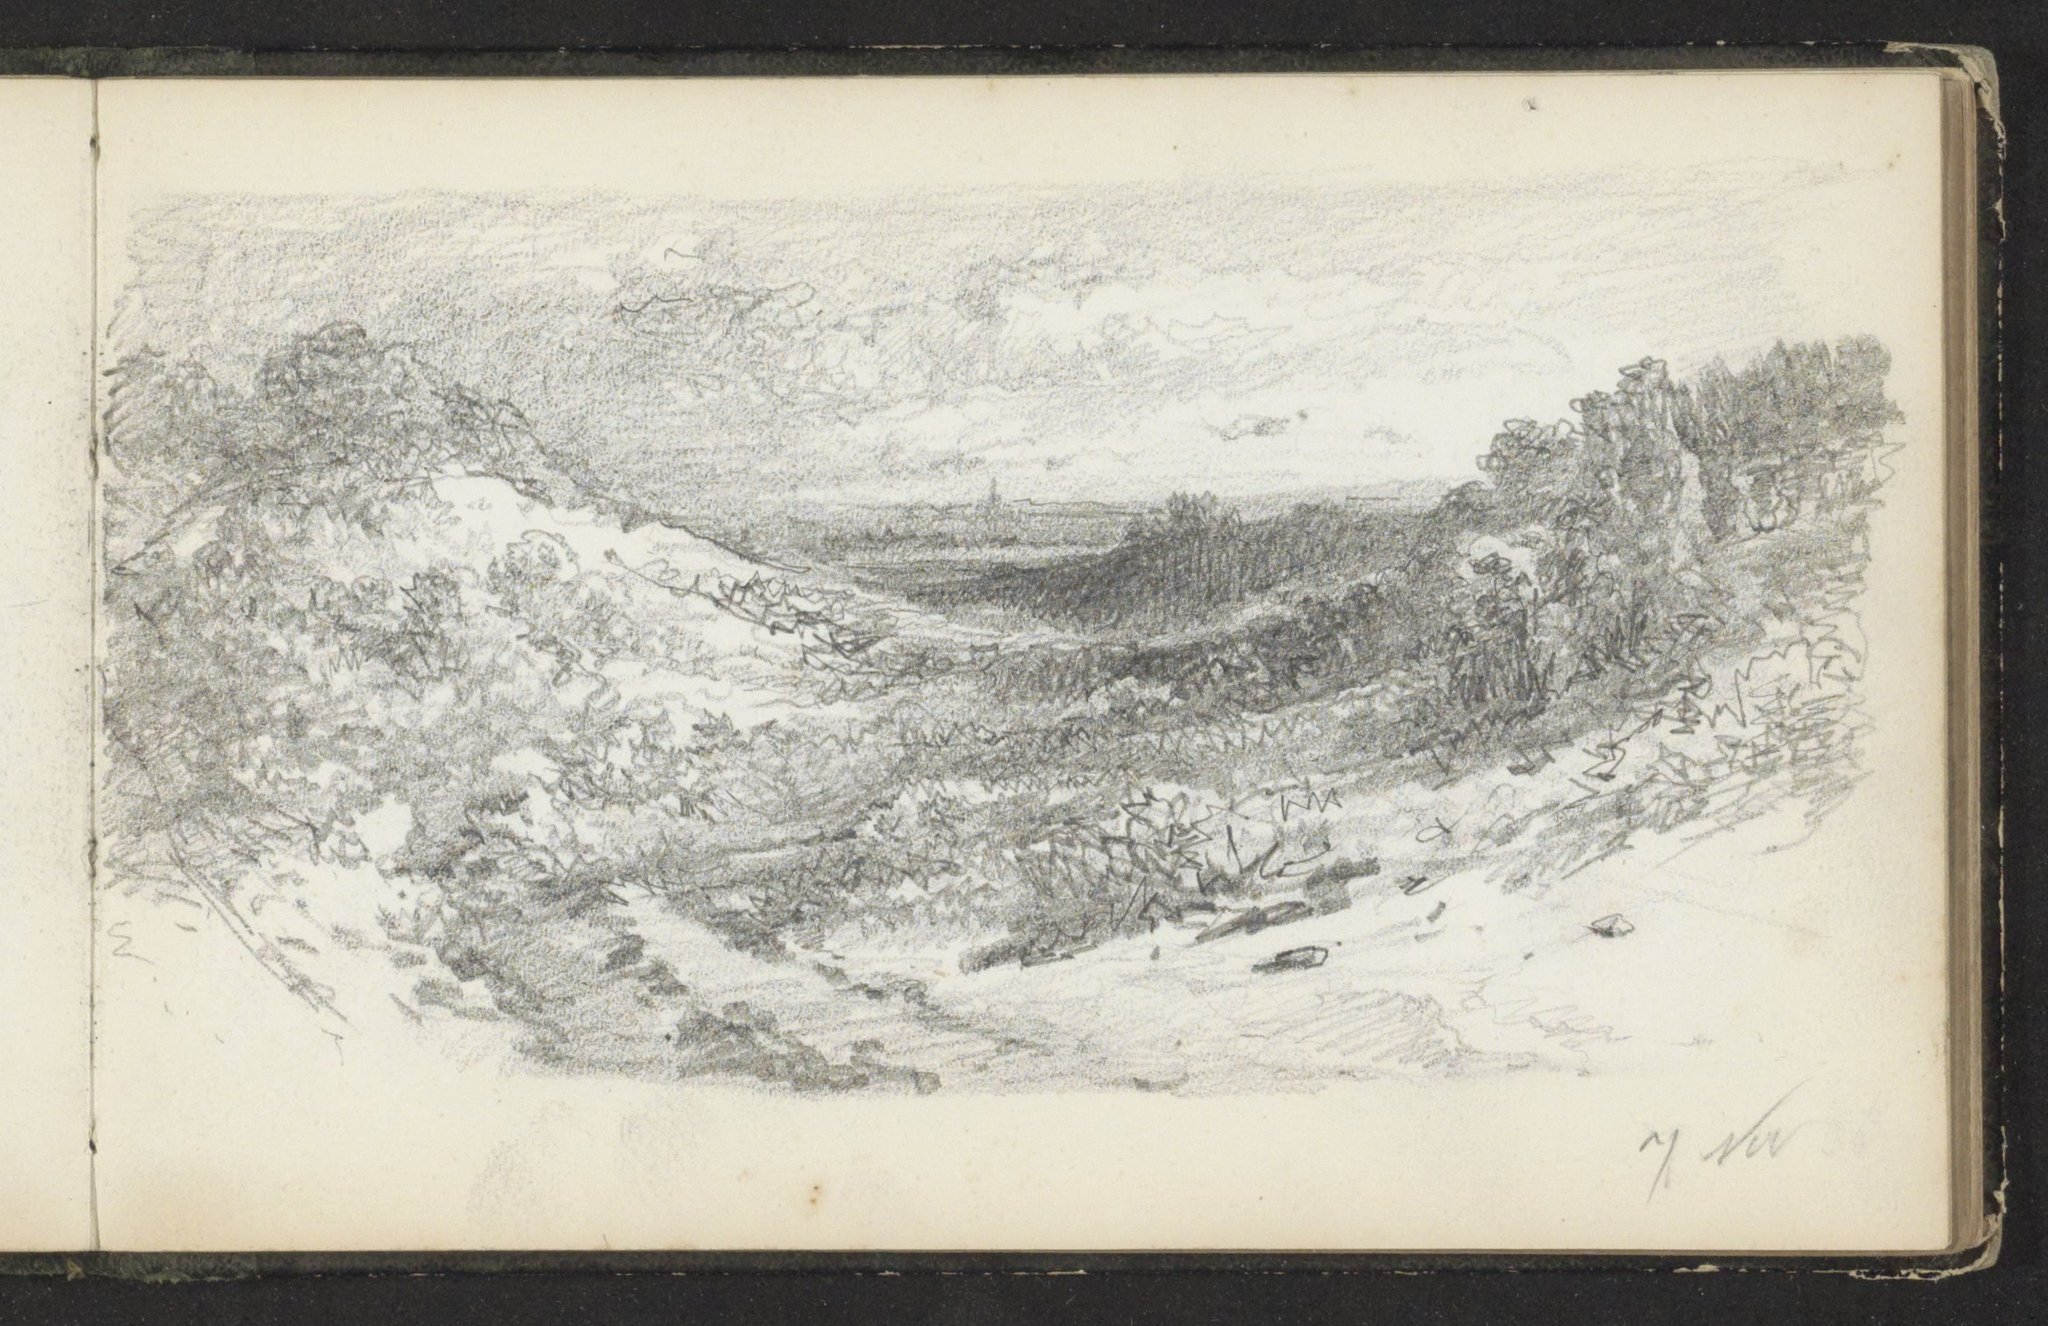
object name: sketchbook leaf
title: Heuvellandschap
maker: maria vos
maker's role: draughtsman, painter, print maker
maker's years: 1824-1906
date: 1811-1856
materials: paper, pencil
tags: low hill country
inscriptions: date: ‘7 Nov’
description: Blad 28 recto uit een schetsboek met 39 bladen.